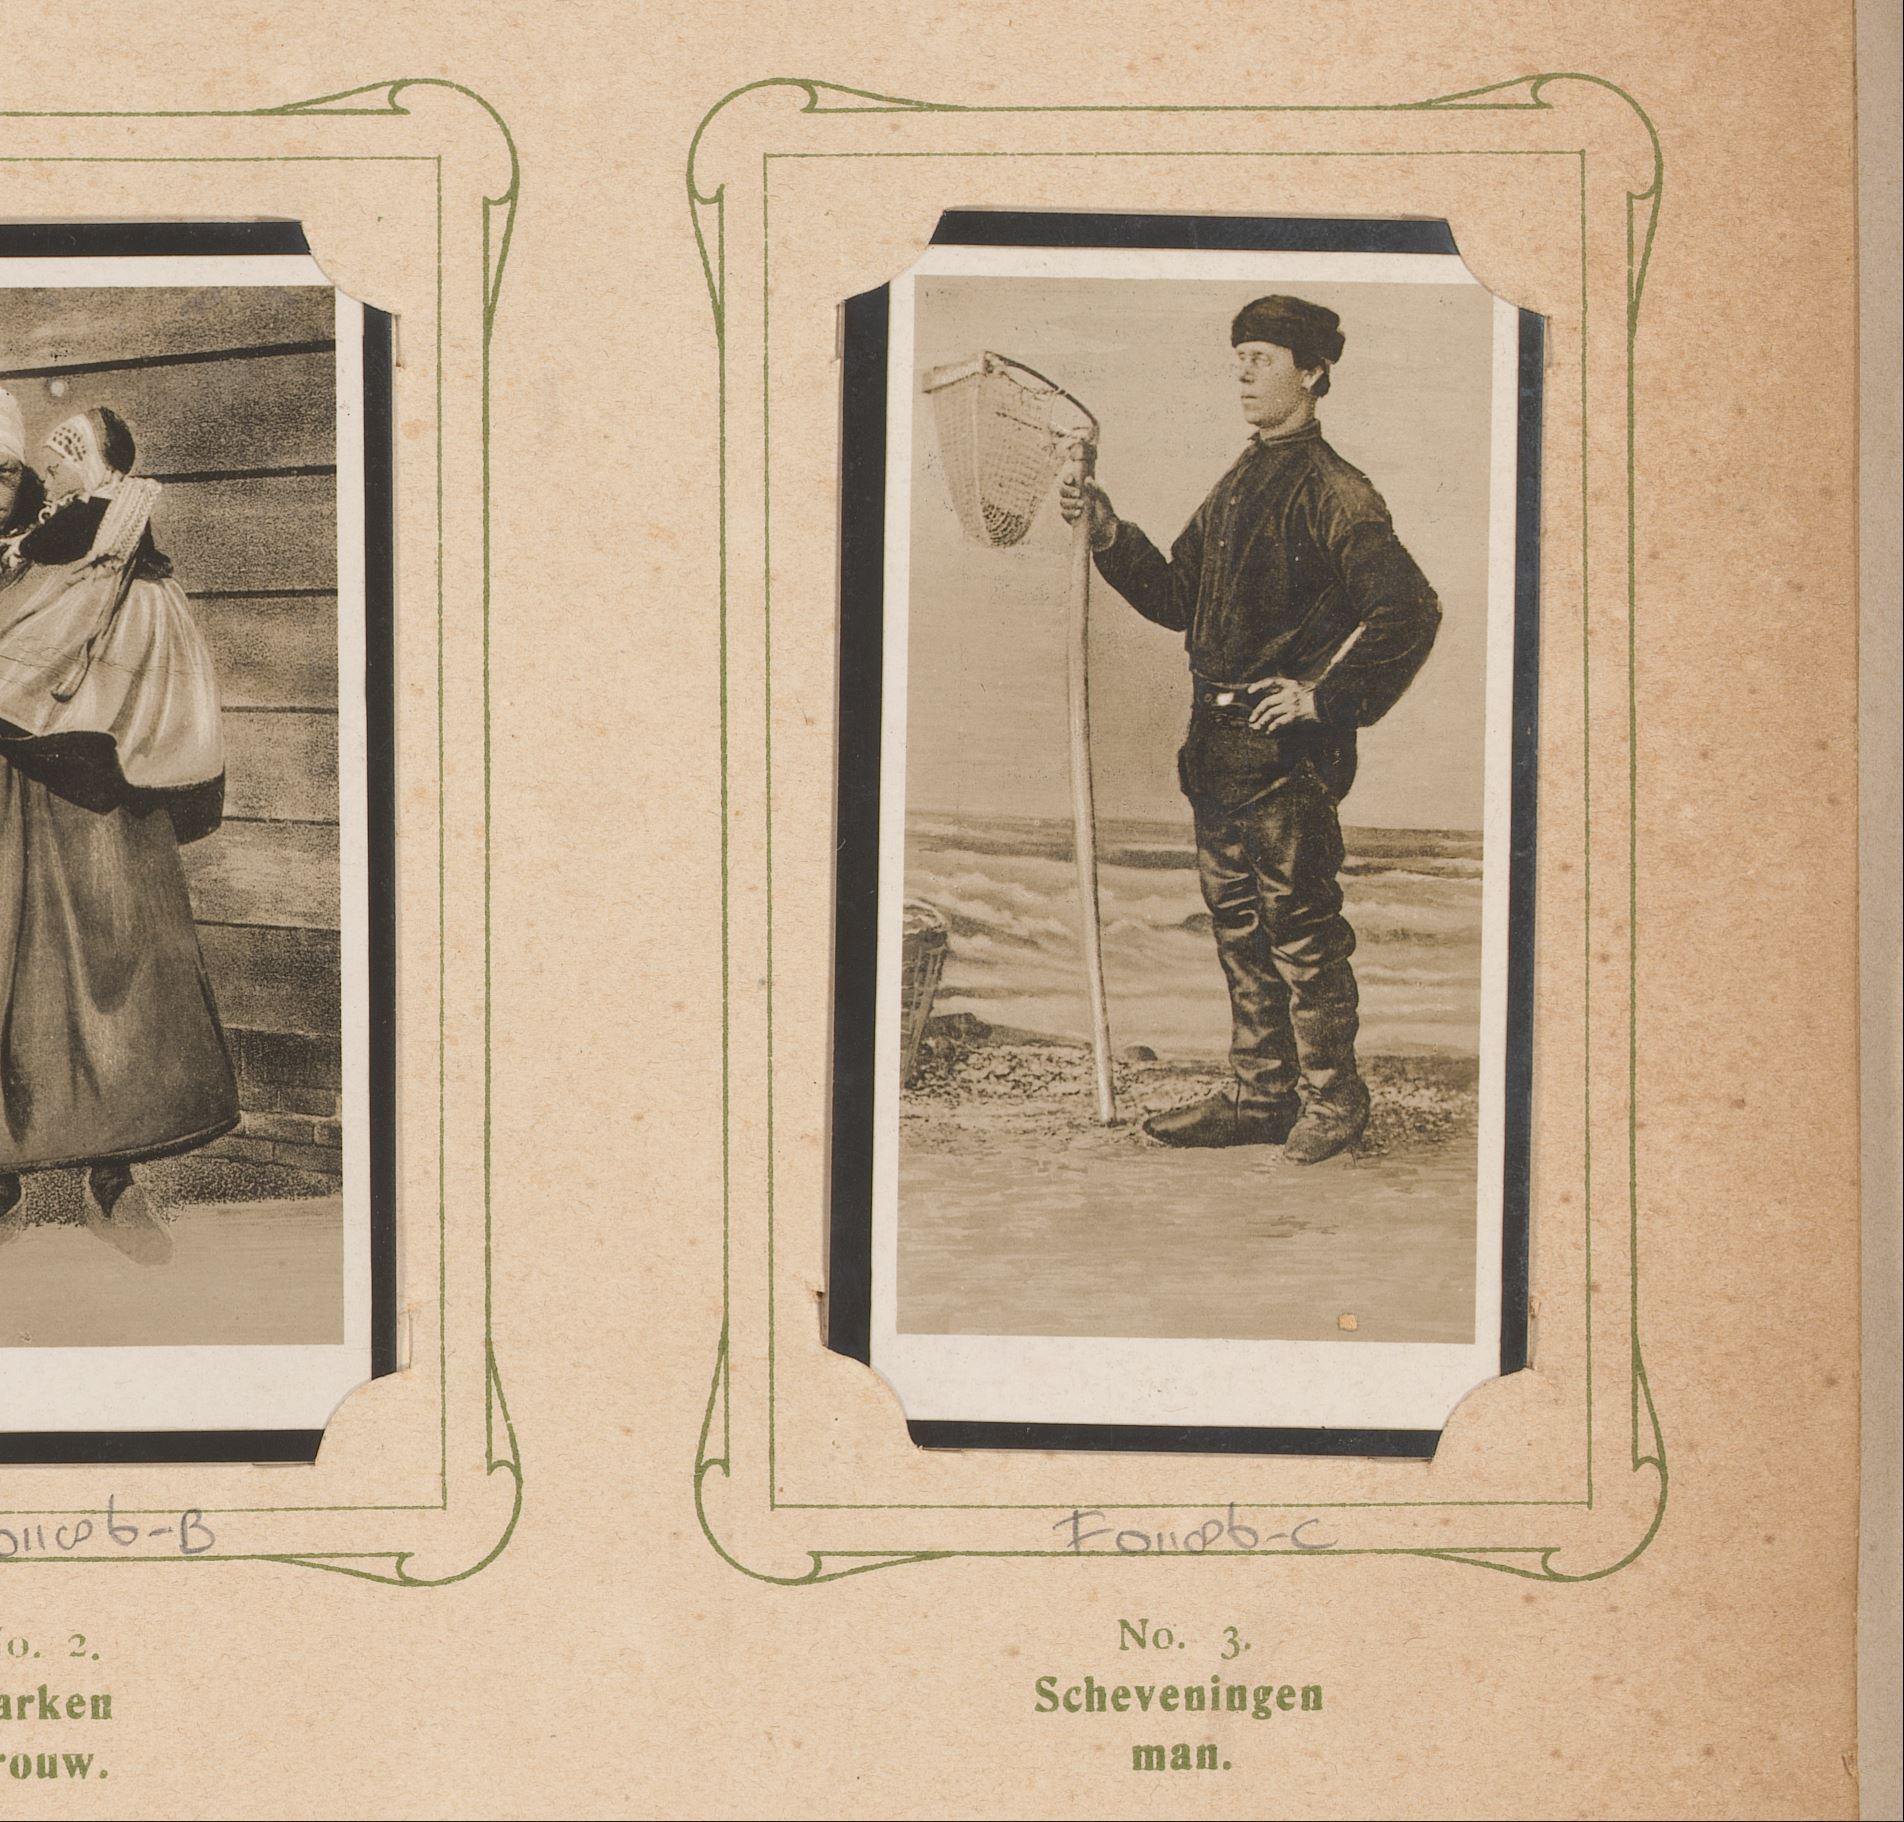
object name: album leaf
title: Portret van een man met schepnet in Hollandse klederdracht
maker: Anonymous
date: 1904-1905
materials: photographic support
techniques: gelatin silver print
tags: fishing net, historical persons, folk costume, regional costume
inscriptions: inscription: ‘No. 3./ Scheveningen/ man’